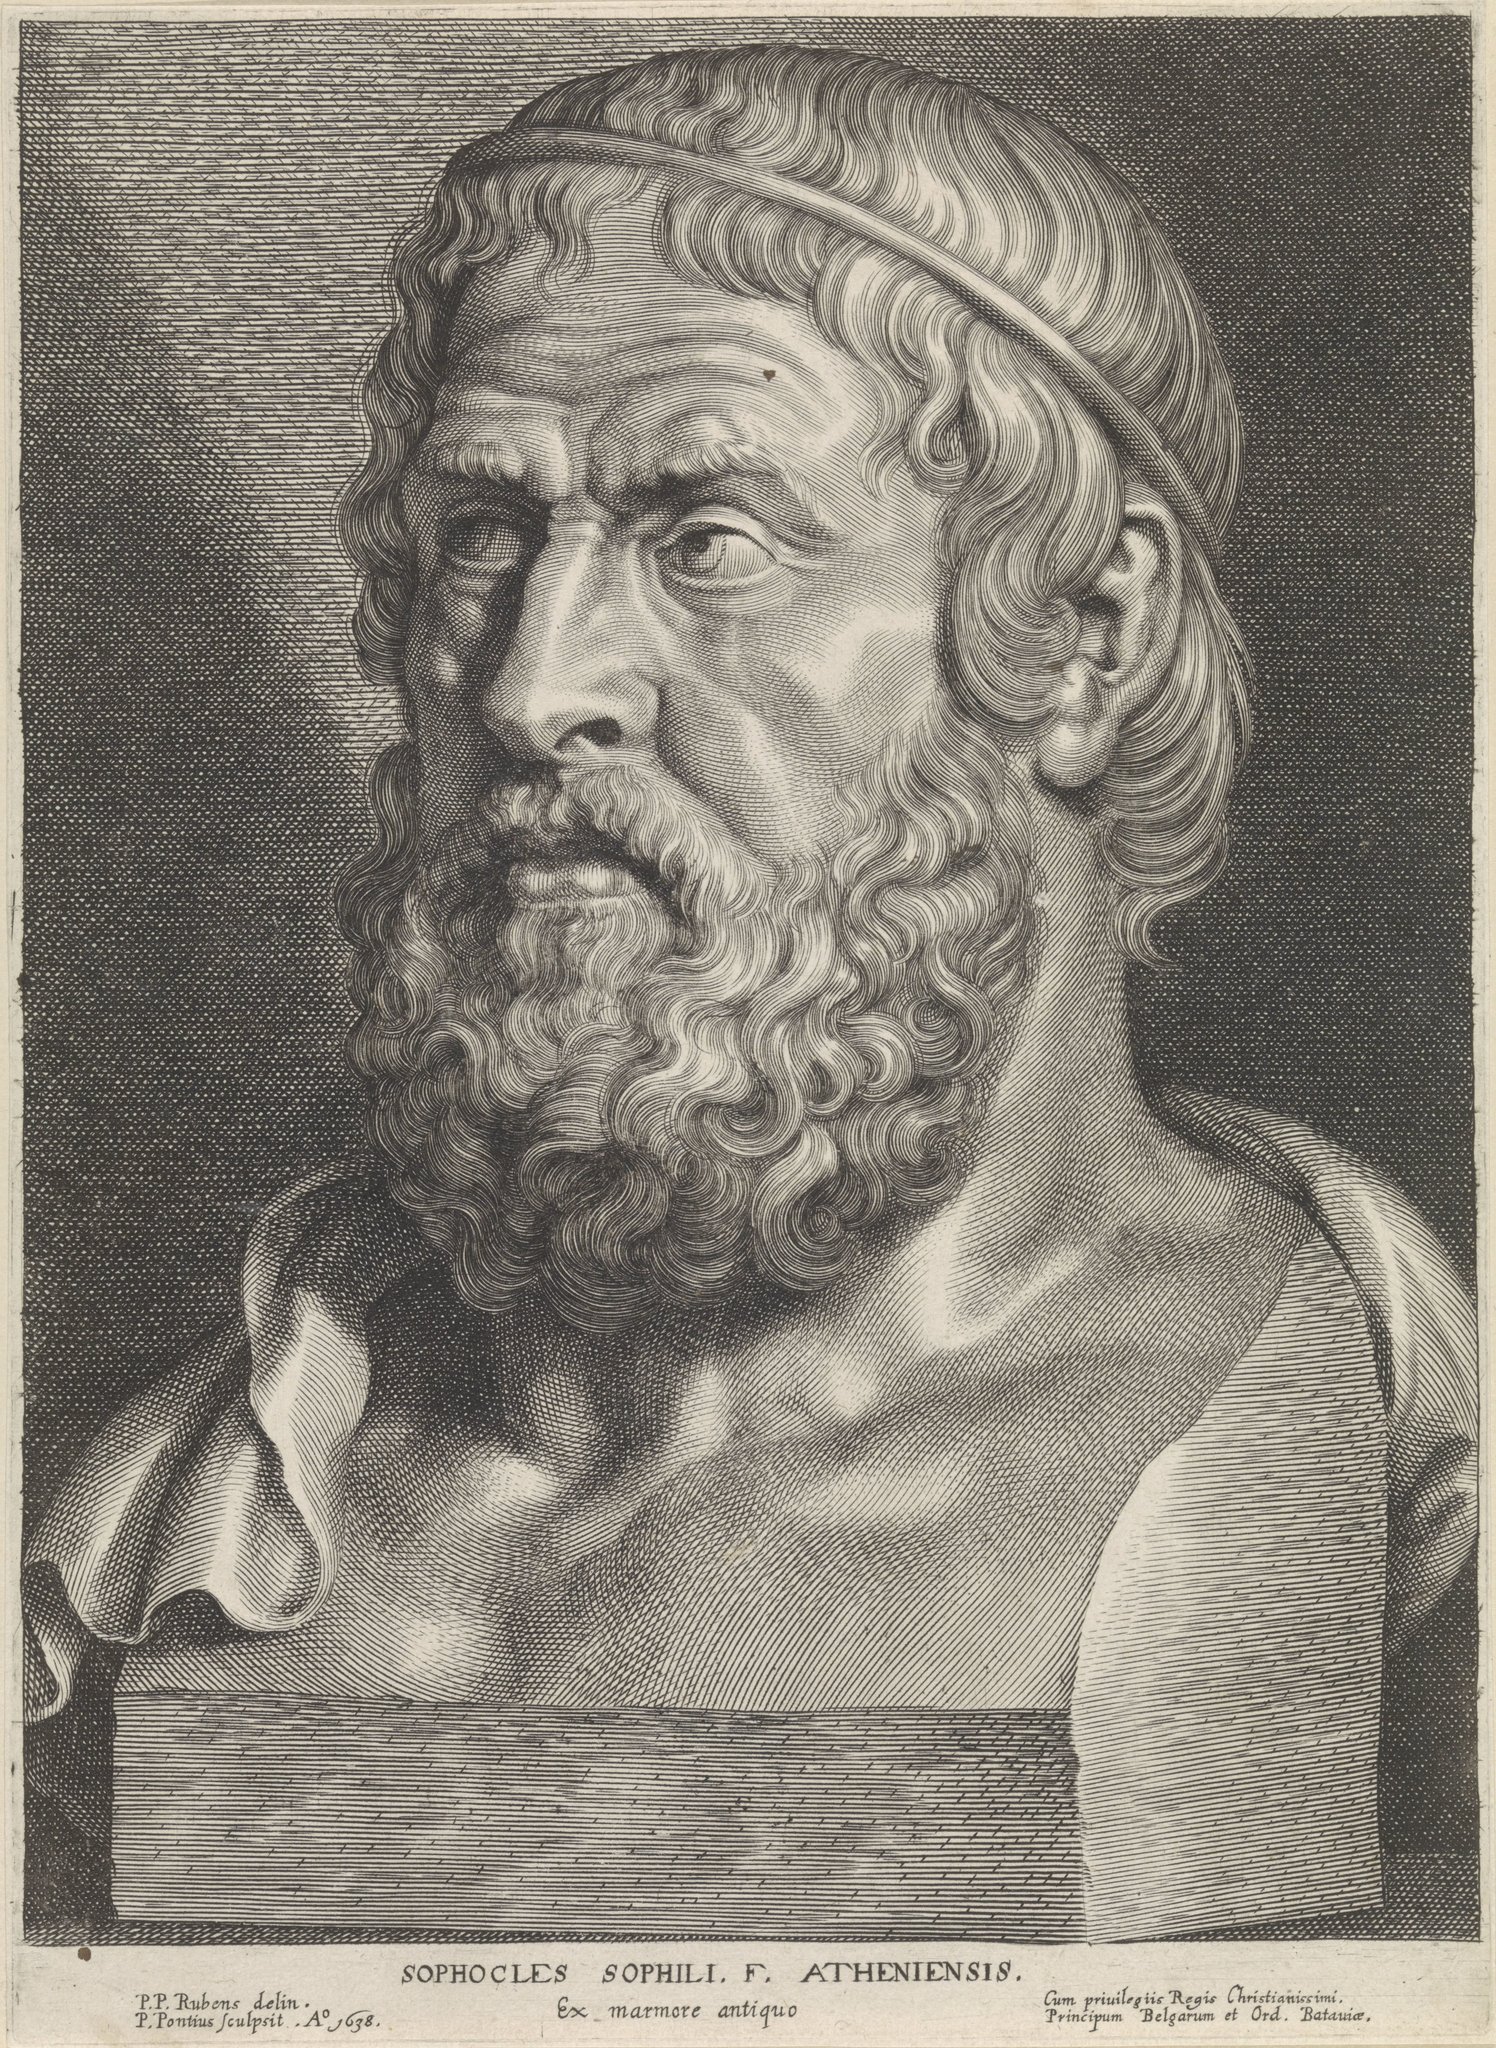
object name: print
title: Antieke buste van Sophocles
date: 1638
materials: paper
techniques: engraving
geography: antwerp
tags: sophocles, piece of sculpture, reproduction of a piece of sculpture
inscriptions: collector's mark: Lugt 240